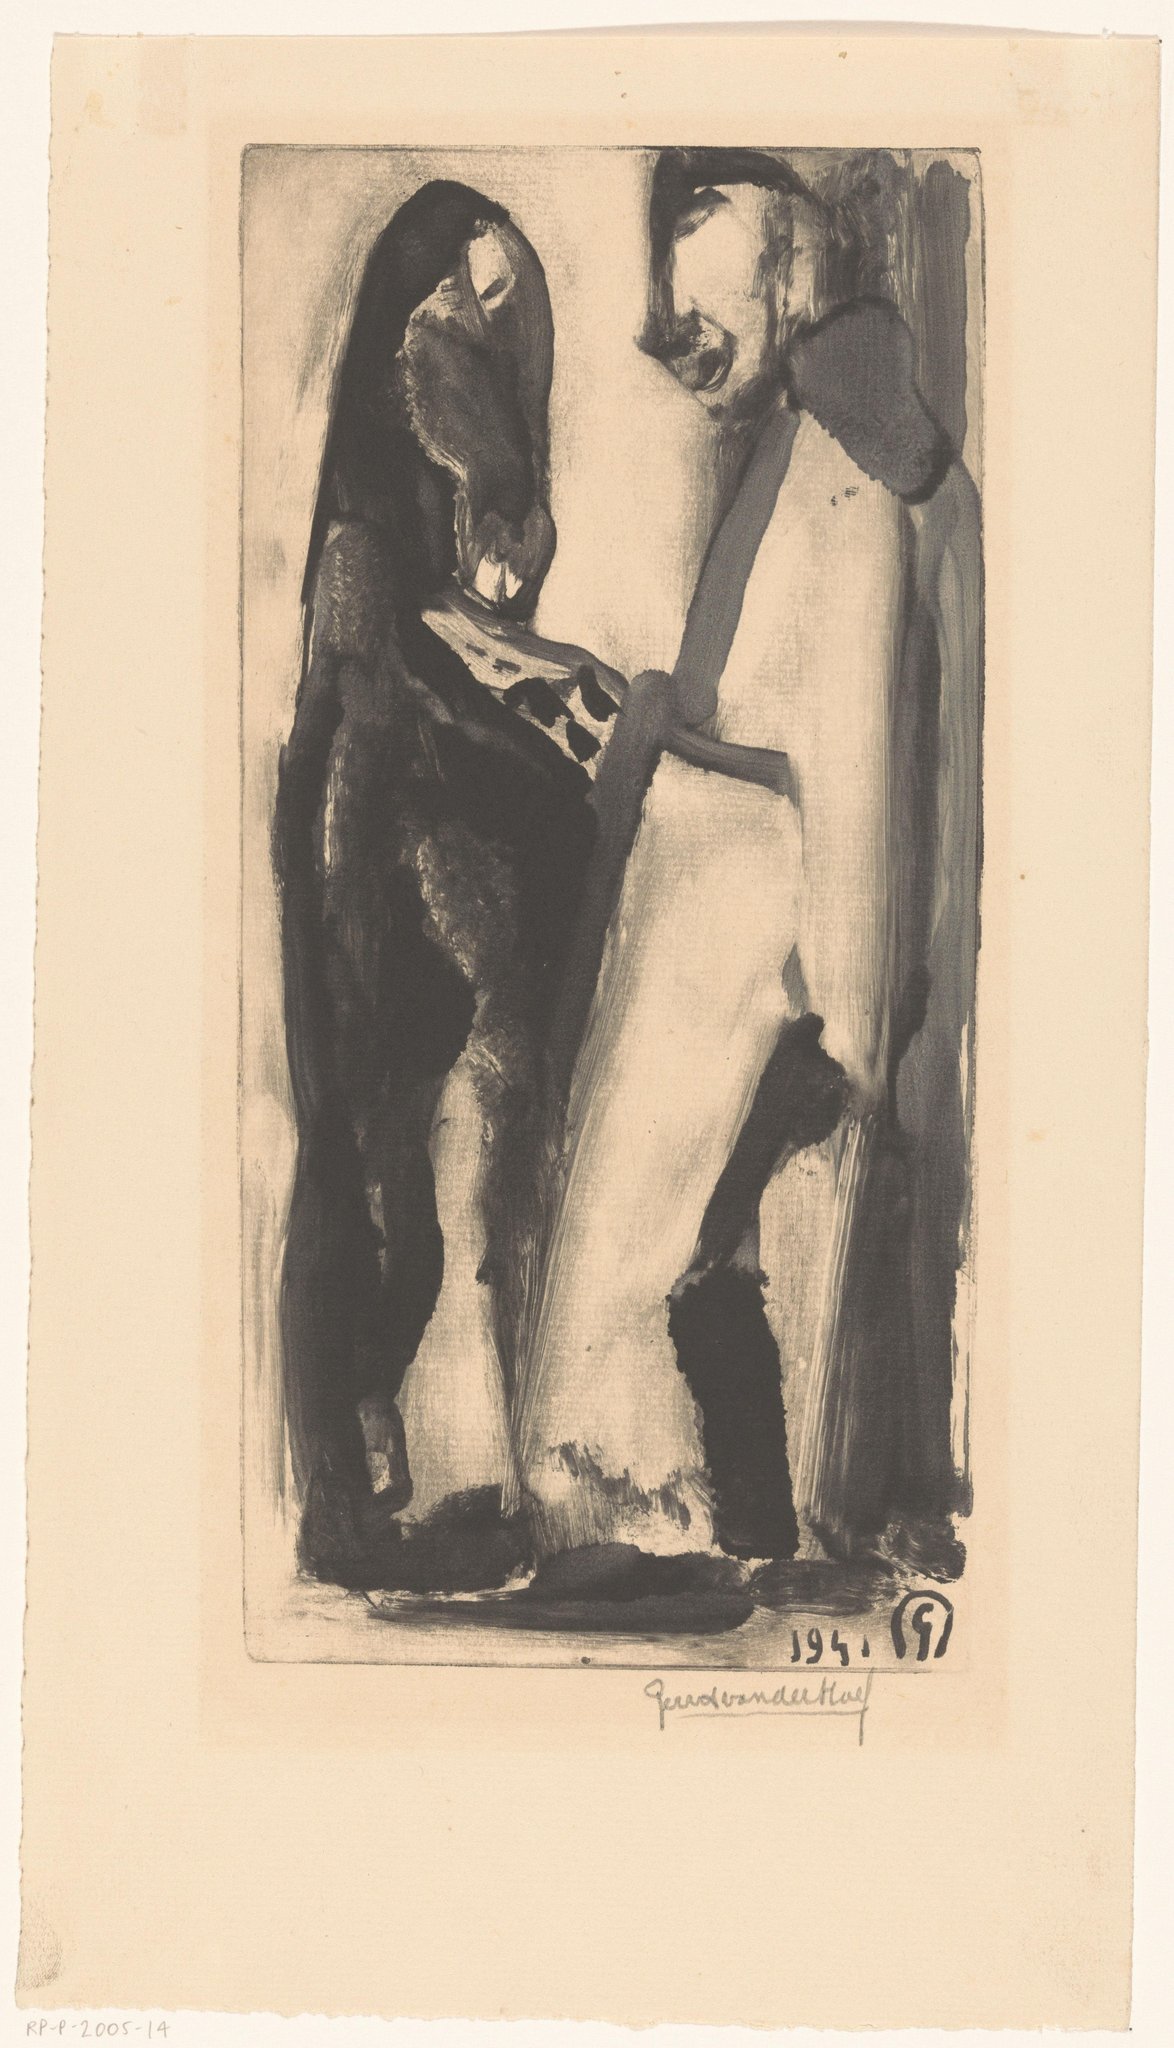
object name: print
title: Twee staande figuren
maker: gerrit van der hoef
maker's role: print maker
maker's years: 1879-1954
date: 1941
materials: paper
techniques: monotype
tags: standing figure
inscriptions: collector's mark: Lugt 2760, collector's mark: Lugt 2228